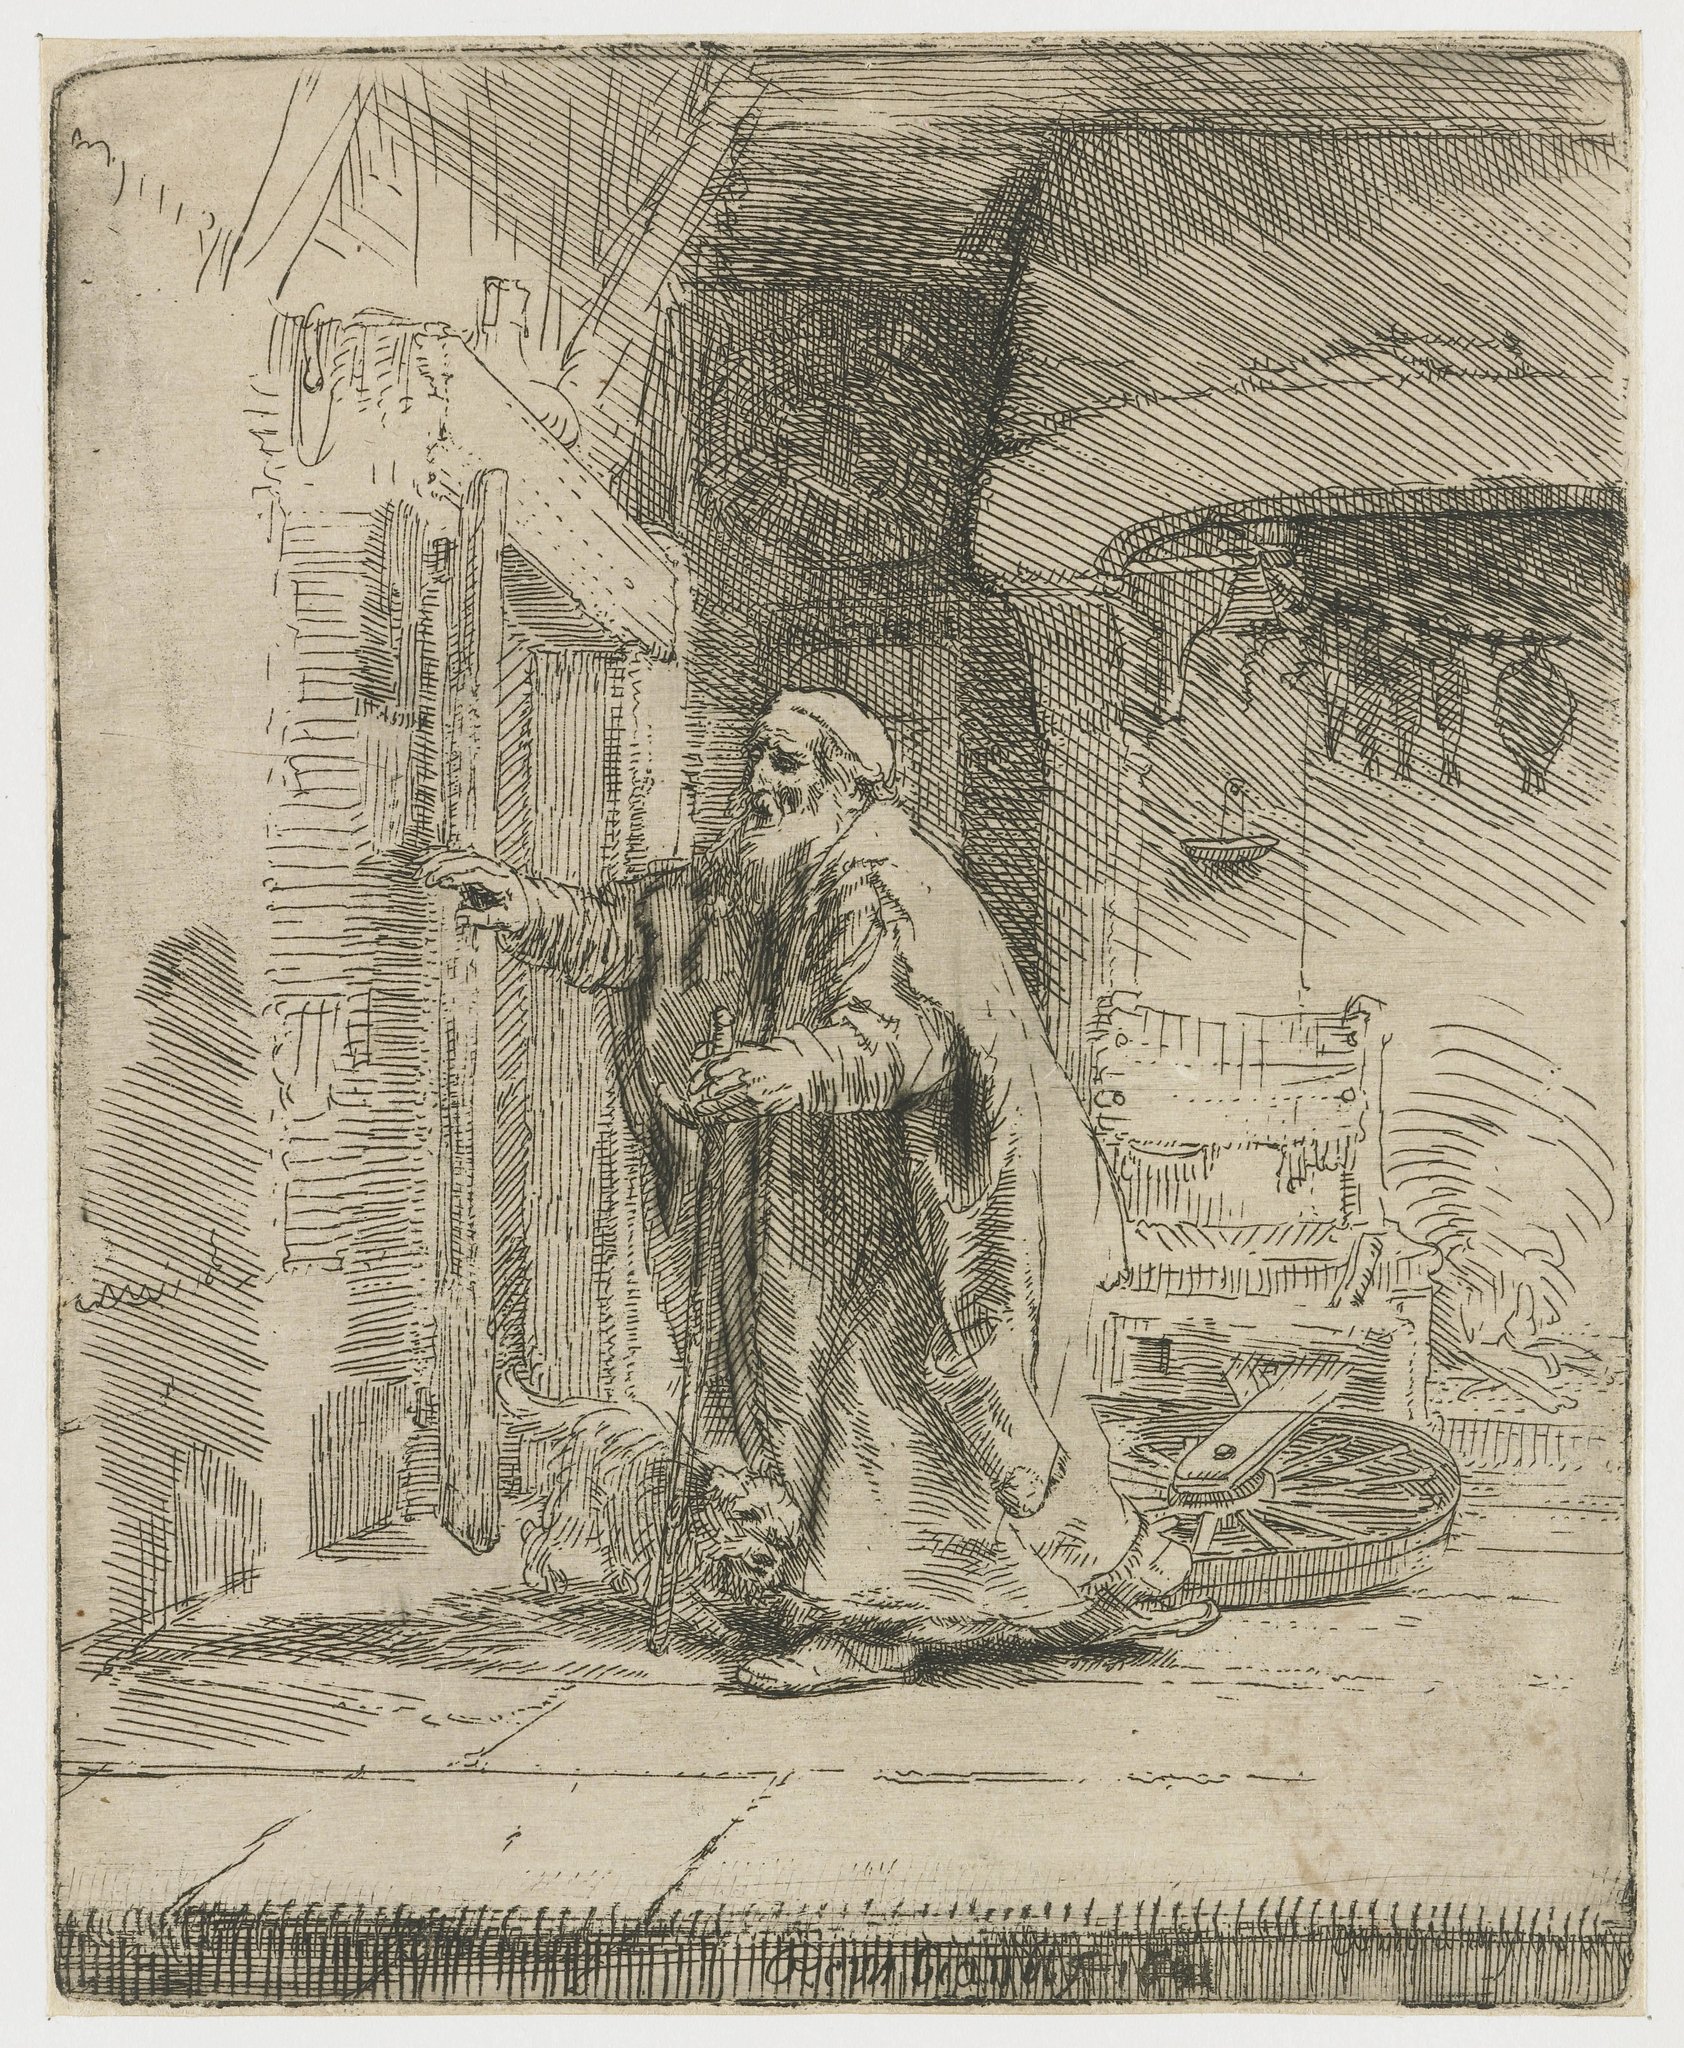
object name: print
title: The blindness of Tobit: the larger plate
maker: rembrandt van rijn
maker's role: draughtsman, painter, print maker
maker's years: 1606-1669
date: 1651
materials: paper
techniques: drypoint, etching, intaglio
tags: tobit's blindness (tobit 2 - 3:6)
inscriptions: collector's mark: Lugt 240, signature and date: ‘Rembrandt f. 1651’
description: Here we witness recognizable human emotions. When Anna, Tobit’s wife, tells him that she sees their long-awaited son, Tobias, arriving, he jumps up excitedly to meet him. However, he is blind and, in his haste, bumps into the door. Rembrandt etched this episode twice, first around 1629 and again in 1651.